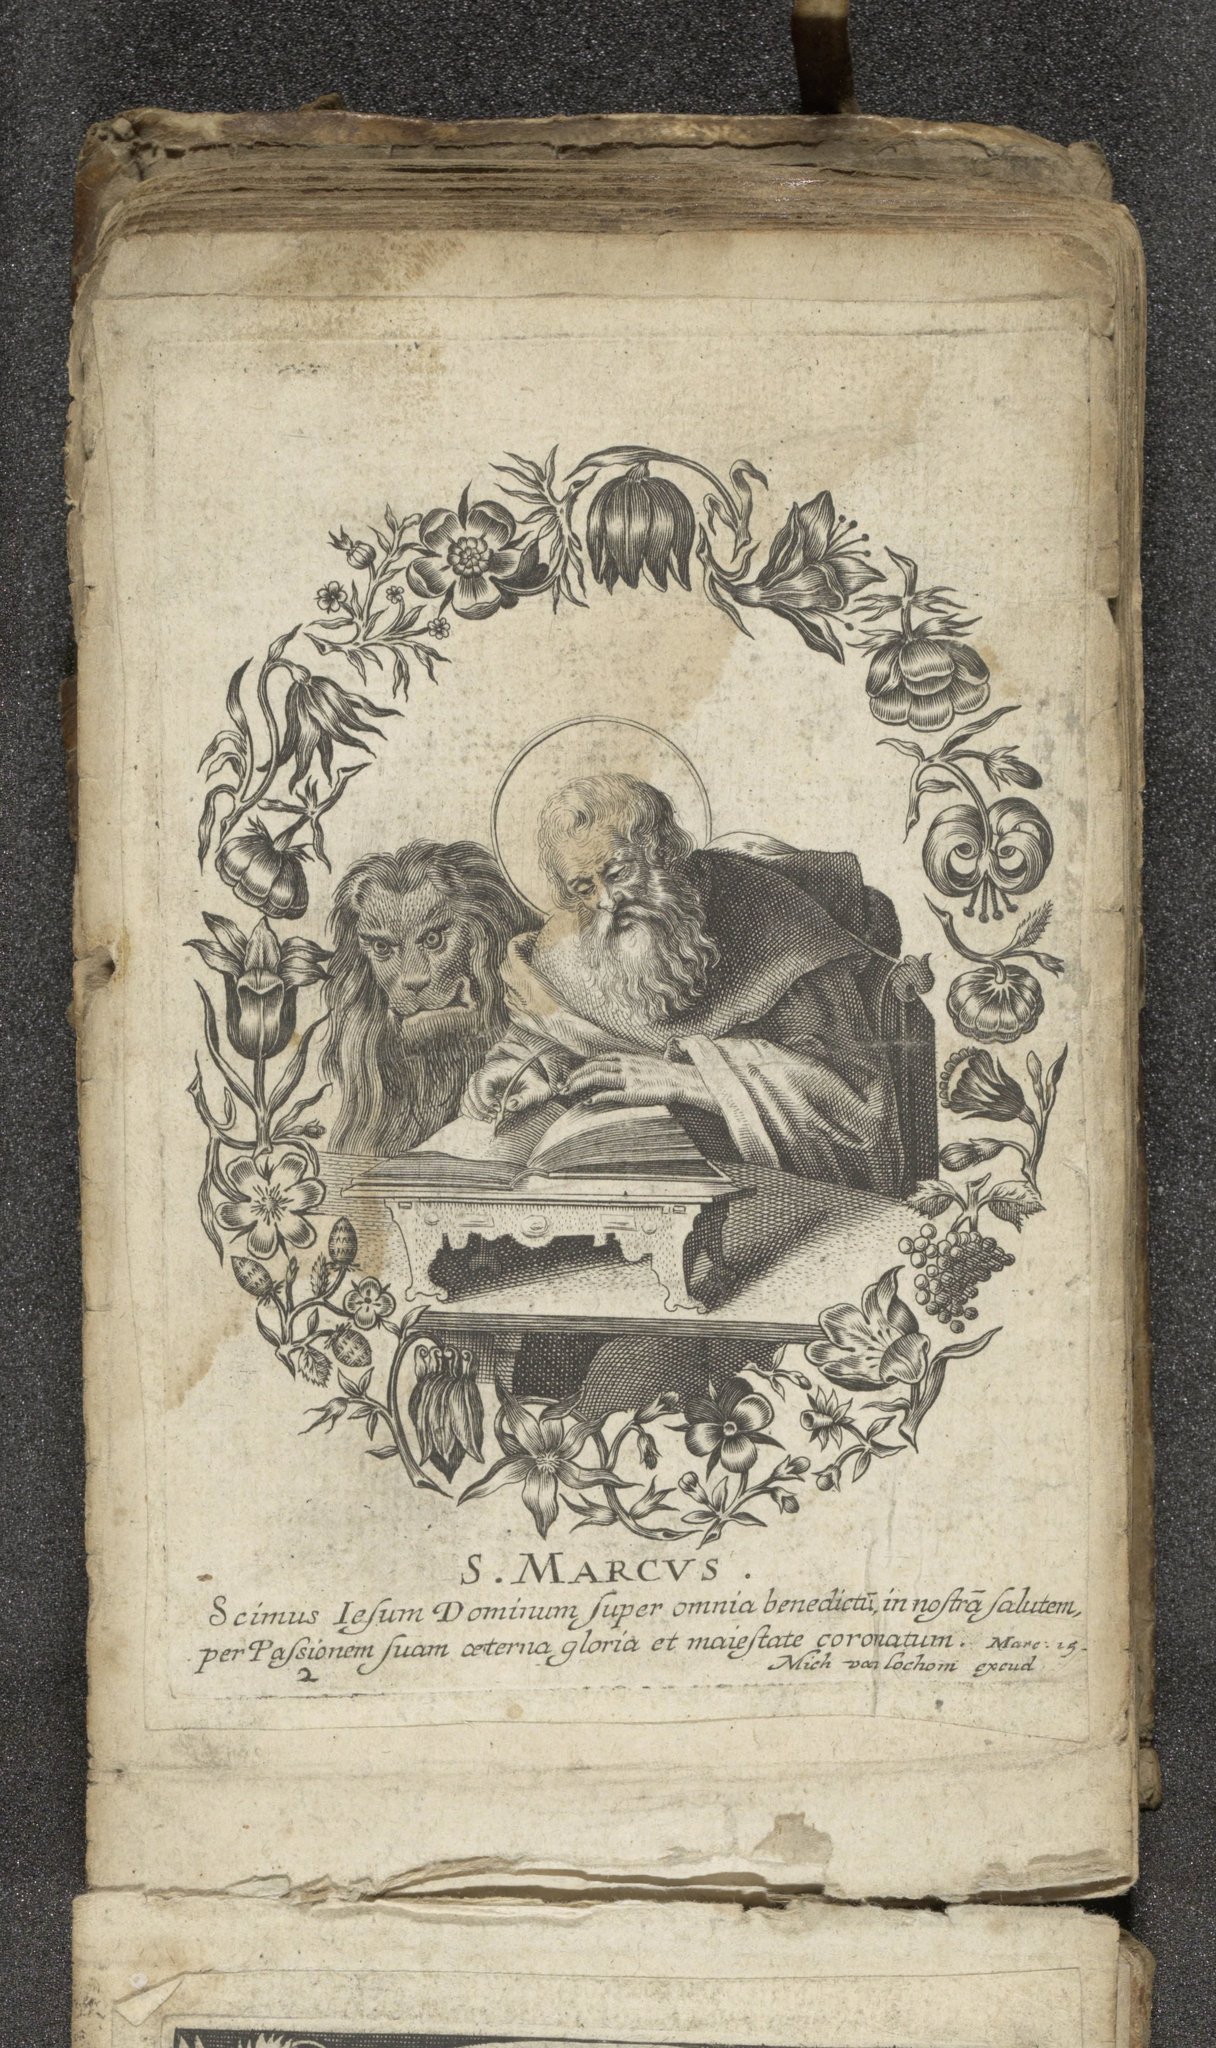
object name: album leaf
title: Evangelist Marcus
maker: michel van lochom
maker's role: print maker, publisher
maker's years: 1601-1647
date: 1611-1647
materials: paper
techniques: engraving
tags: st. mark the evangelist writing the gospel, usually a (winged) lion present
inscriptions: inscription: ‘,,(?)’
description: De evangelist Marcus, schrijvend aan een tafel. Achter hem Naast hem zijn attribuut de leeuw. In een omlijsting van bloemen. Twee regels tekst onder de voorstelling, in het Latijn. De prent maakt deel uit van een album.